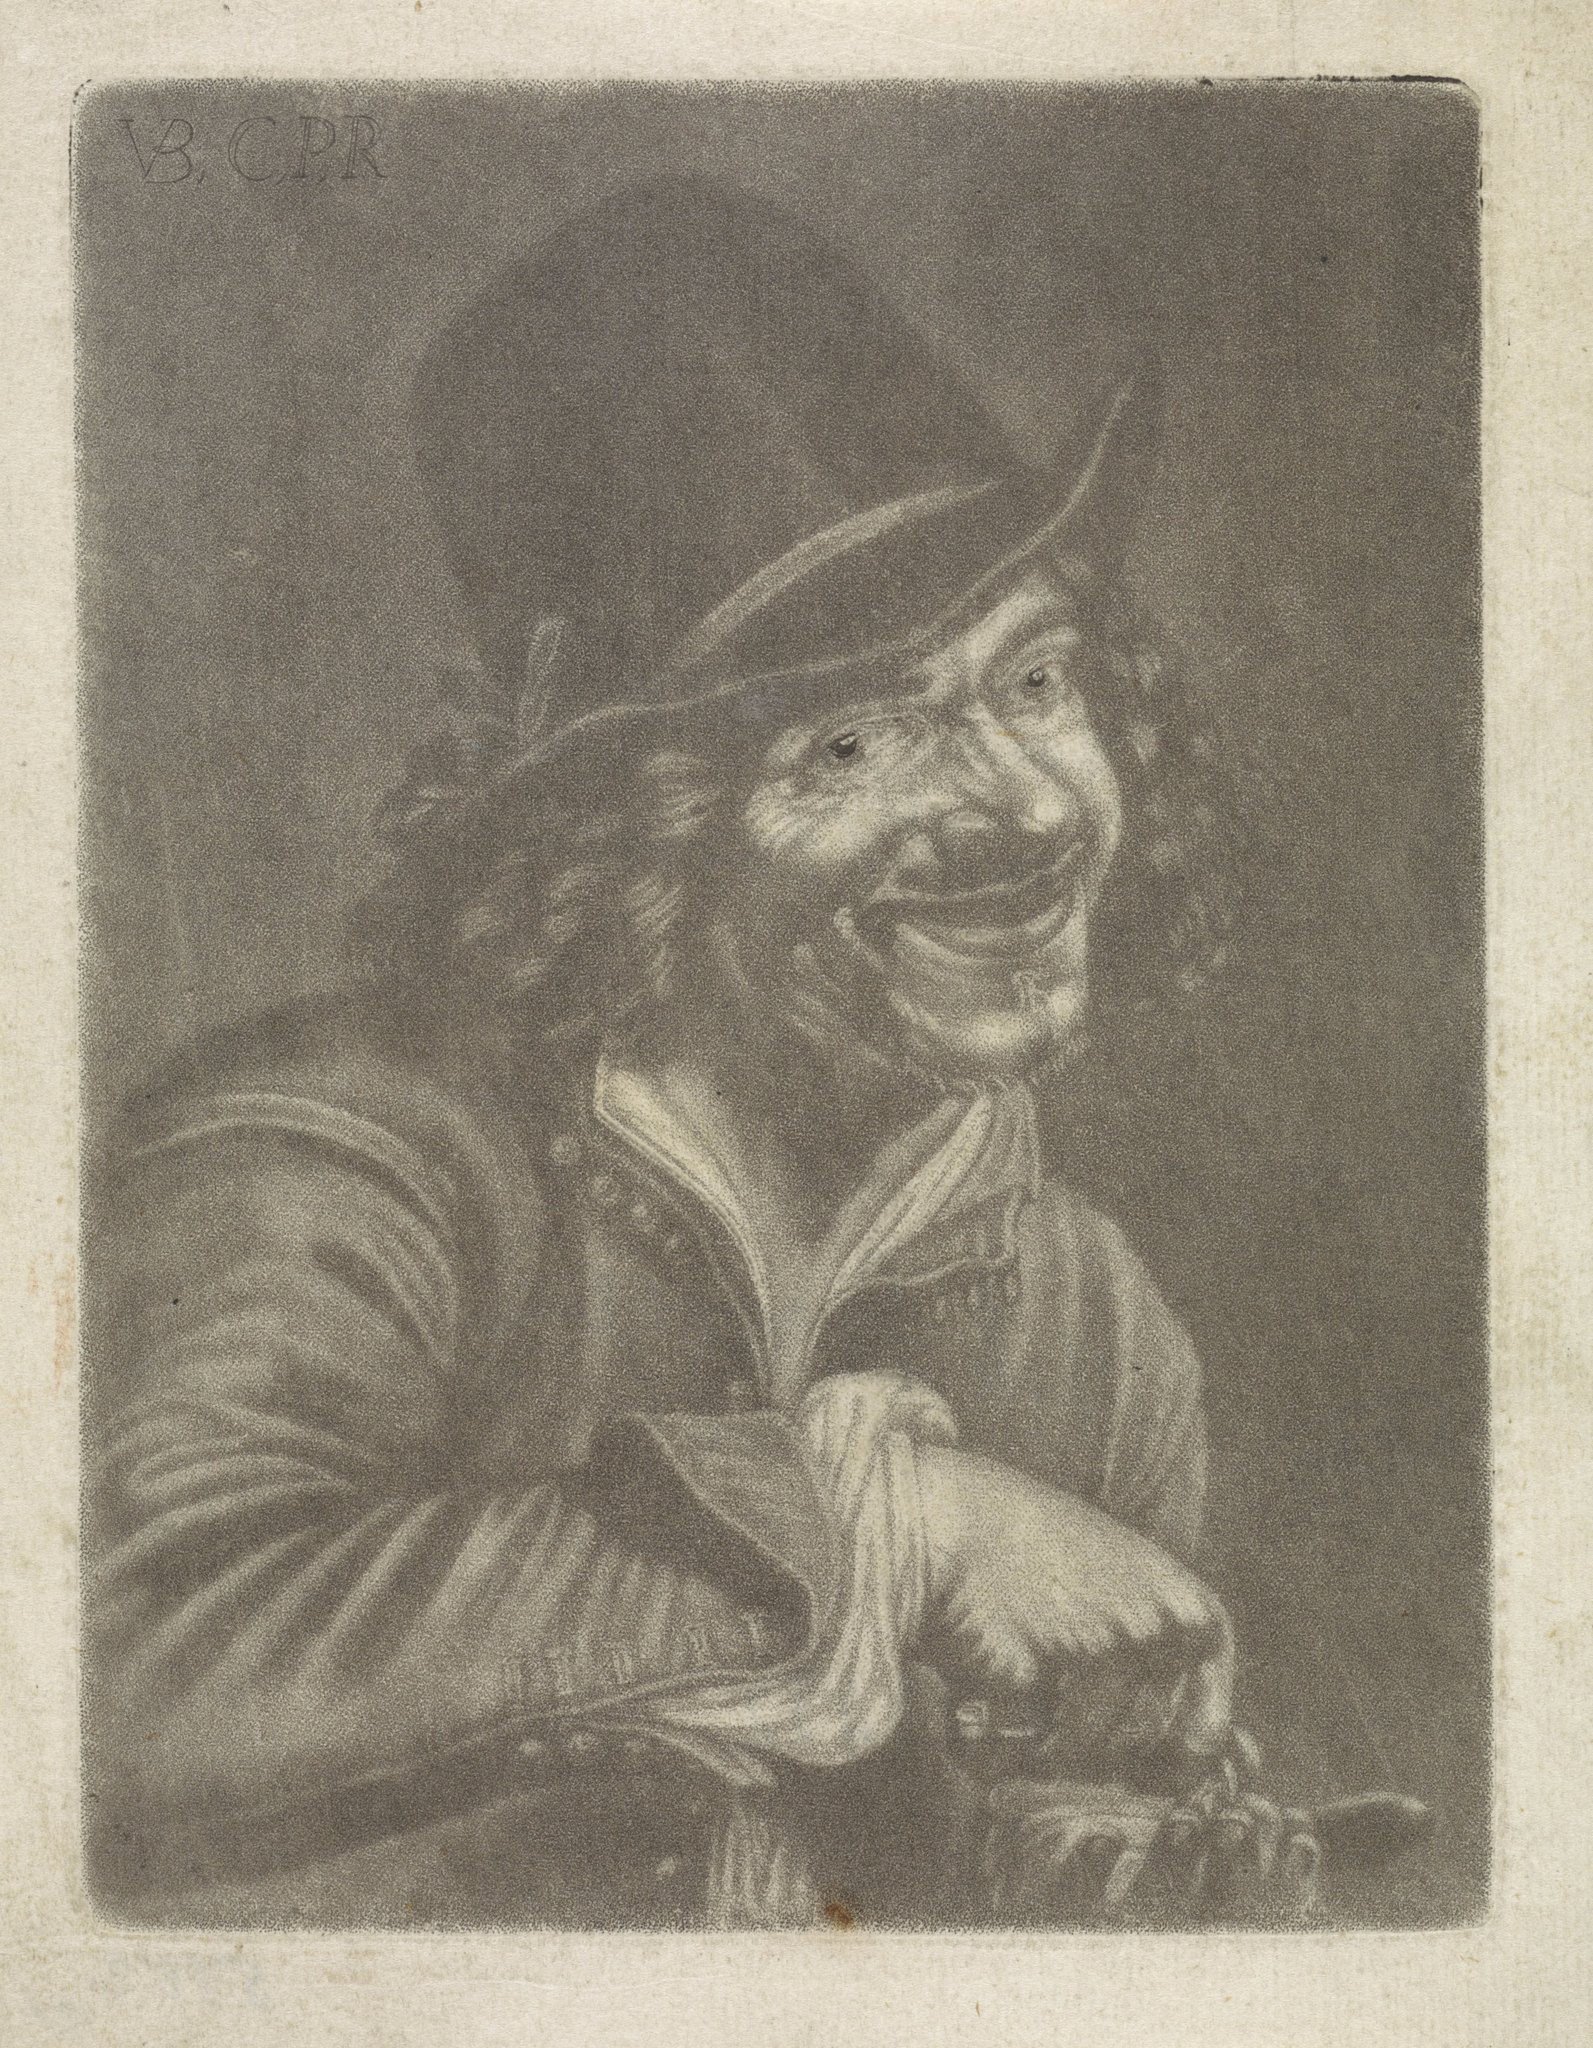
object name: print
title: Man telt munten (het Gehoor)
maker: jan van der bruggen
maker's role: draughtsman, print maker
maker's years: 1649-1709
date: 1659-1740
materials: paper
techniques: engraving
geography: brussels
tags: hearing, listening (one of the five senses), money-changer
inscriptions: collector's mark: Lugt 2228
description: Het Gehoor. Een man met een hoed op telt geldstukken. De prent maakt deel uit van een serie met de vijf zintuigen.